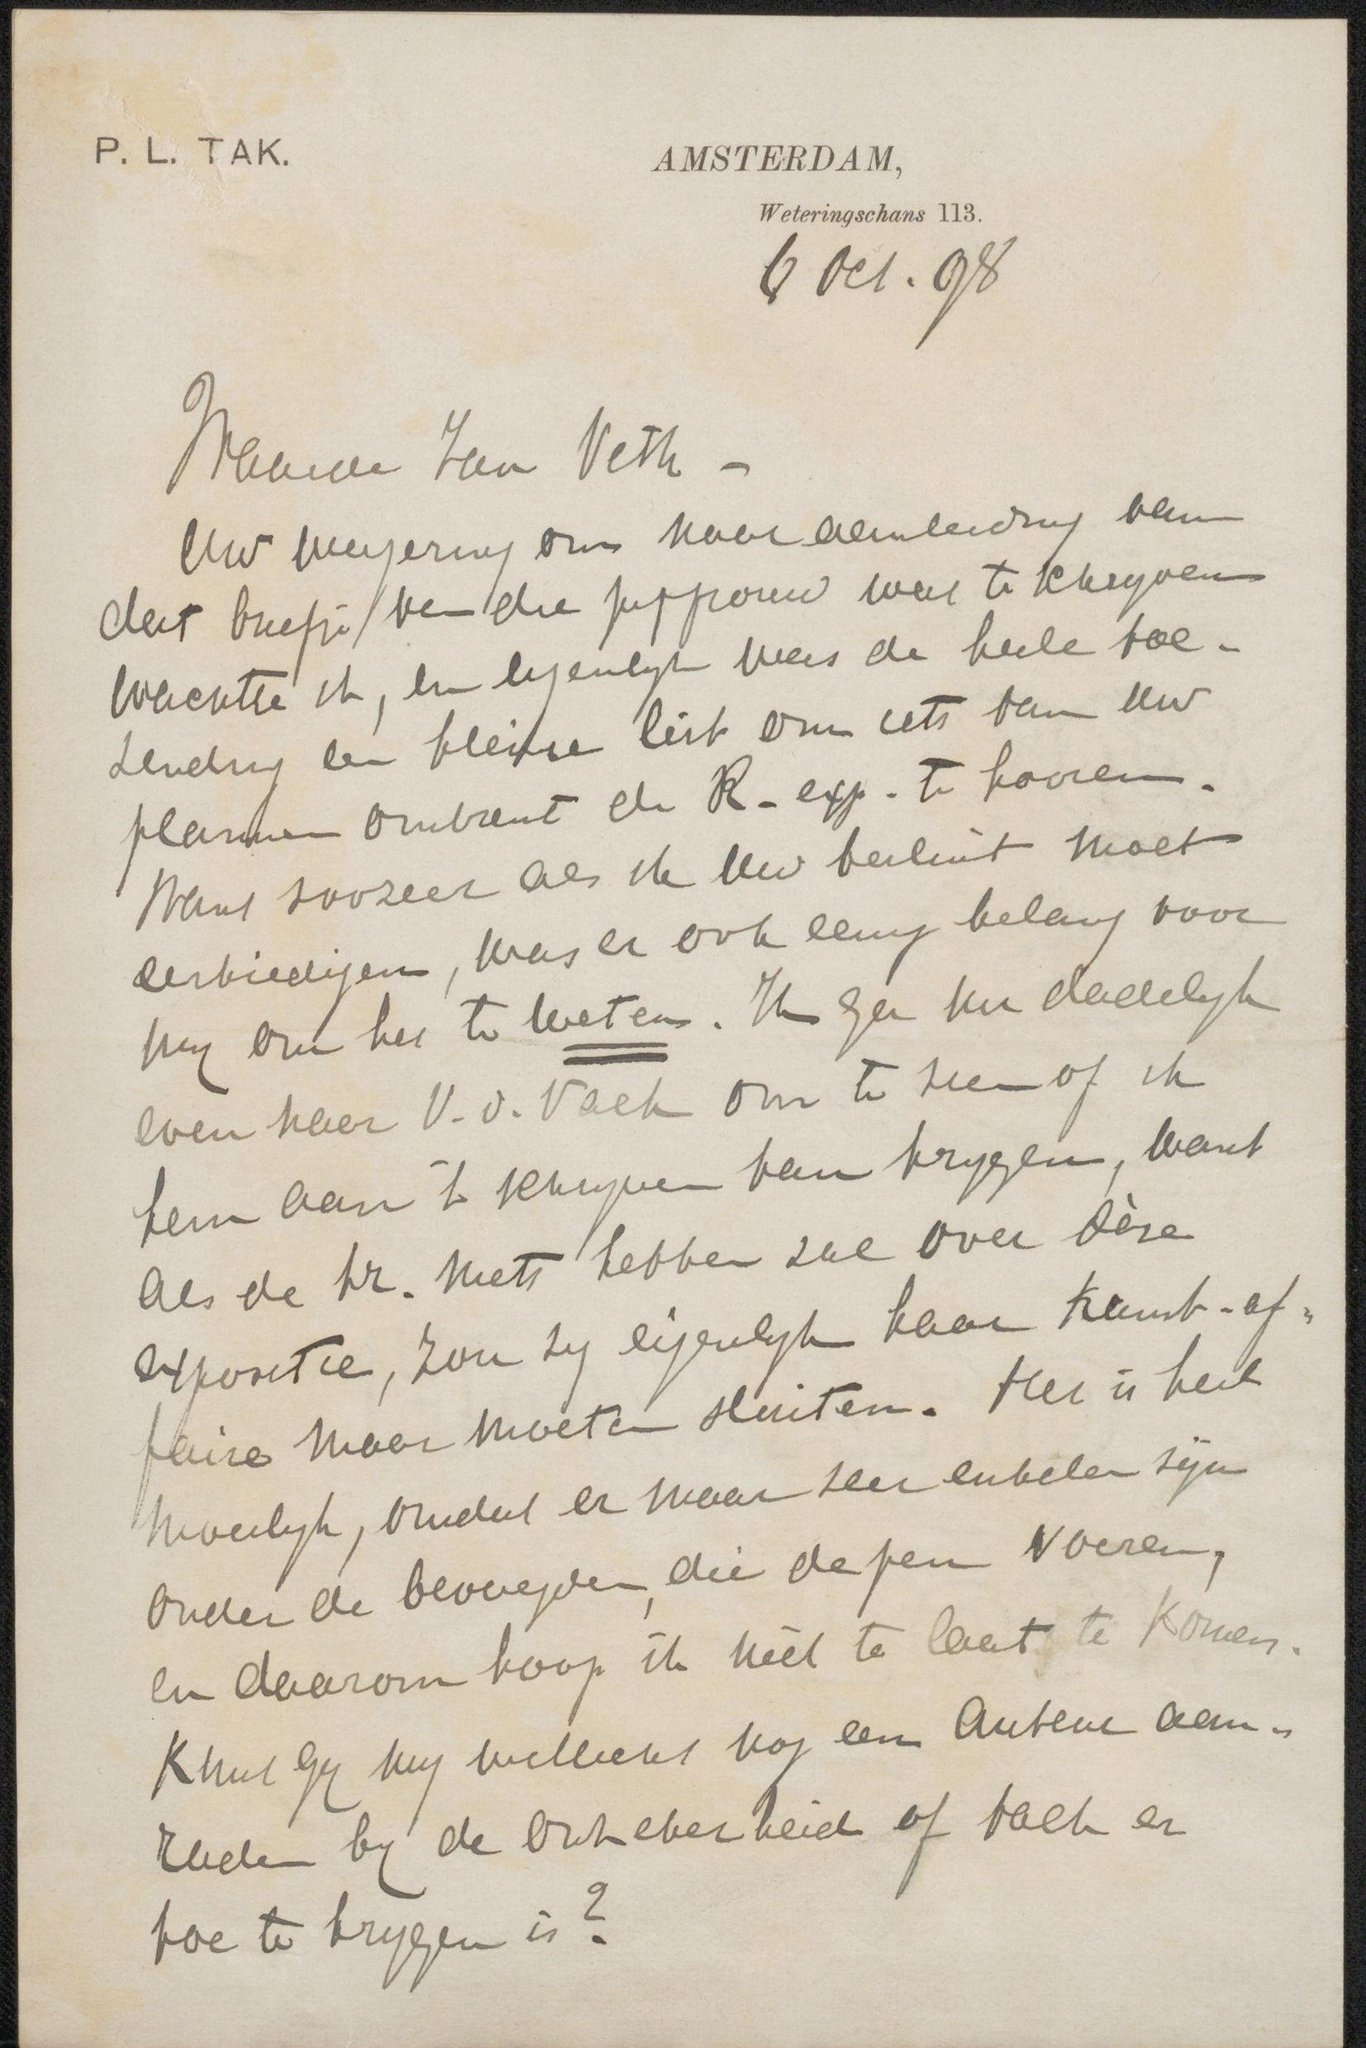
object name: letter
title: Brief aan Jan Veth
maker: pieter lodewijk tak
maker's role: politician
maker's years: 1848-1907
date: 1898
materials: ink, paper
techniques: pen, printing, writing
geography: amsterdam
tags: painter, designer, jan veth, print maker, draughtsman, maurits van der valk, exhibition ~ art, printed matter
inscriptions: watermark, collector's mark: ‘RPK’